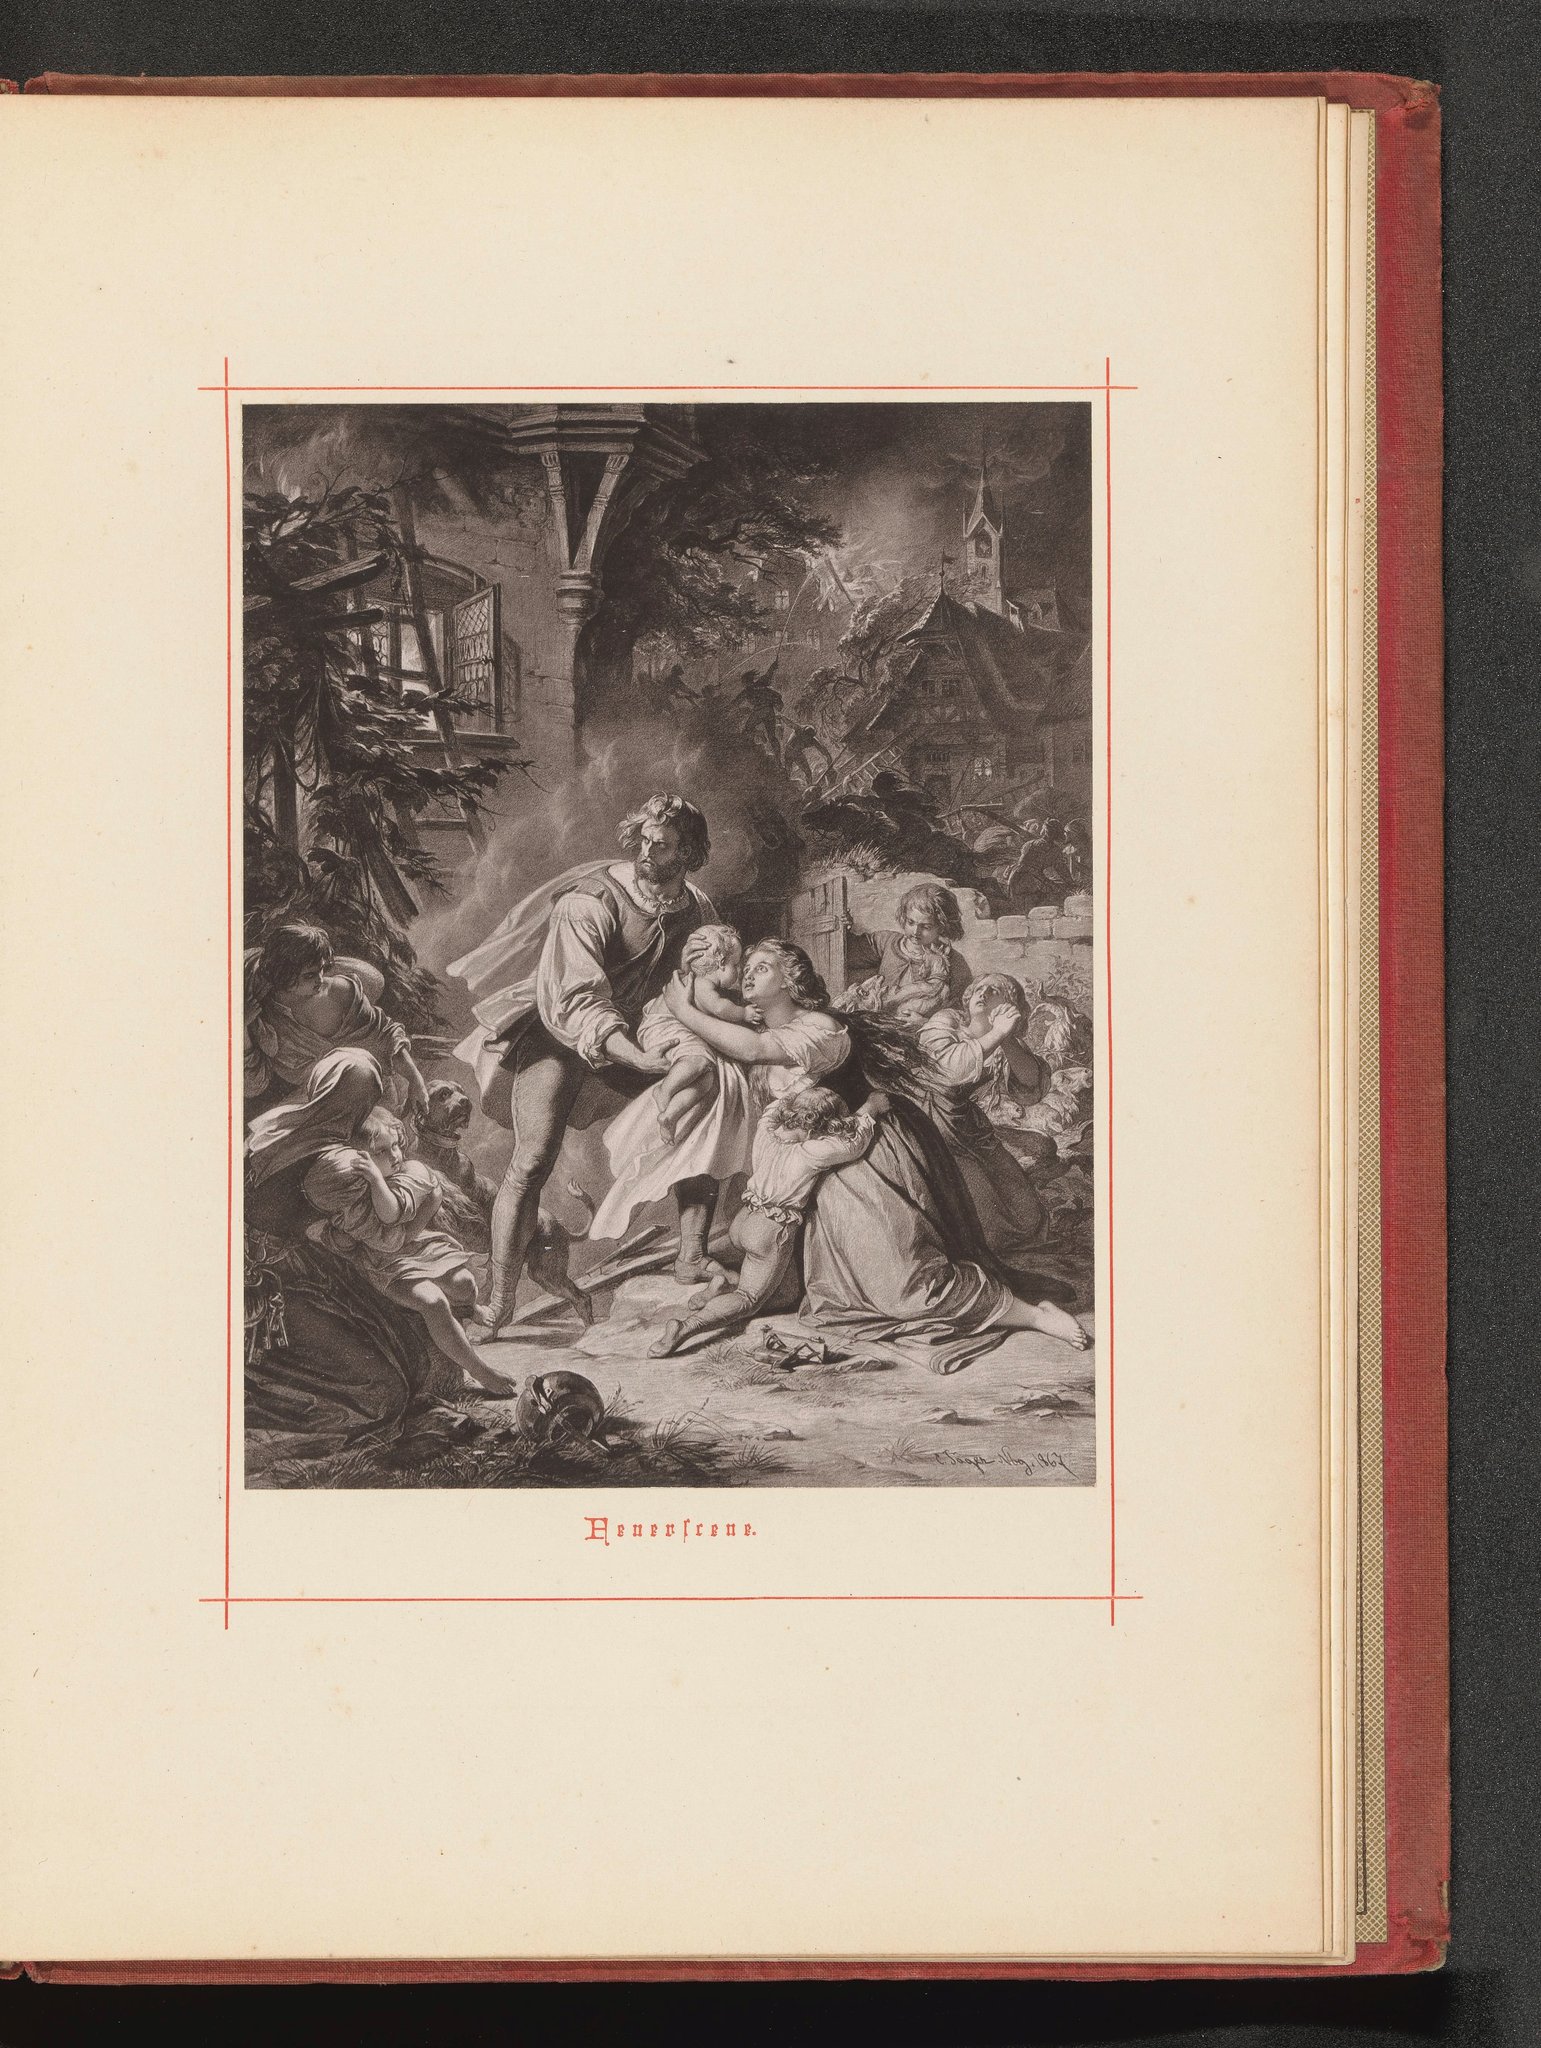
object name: photomechanical print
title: Feuers[...]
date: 1871-1881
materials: paper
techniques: photograph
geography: munich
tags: rescue from fire